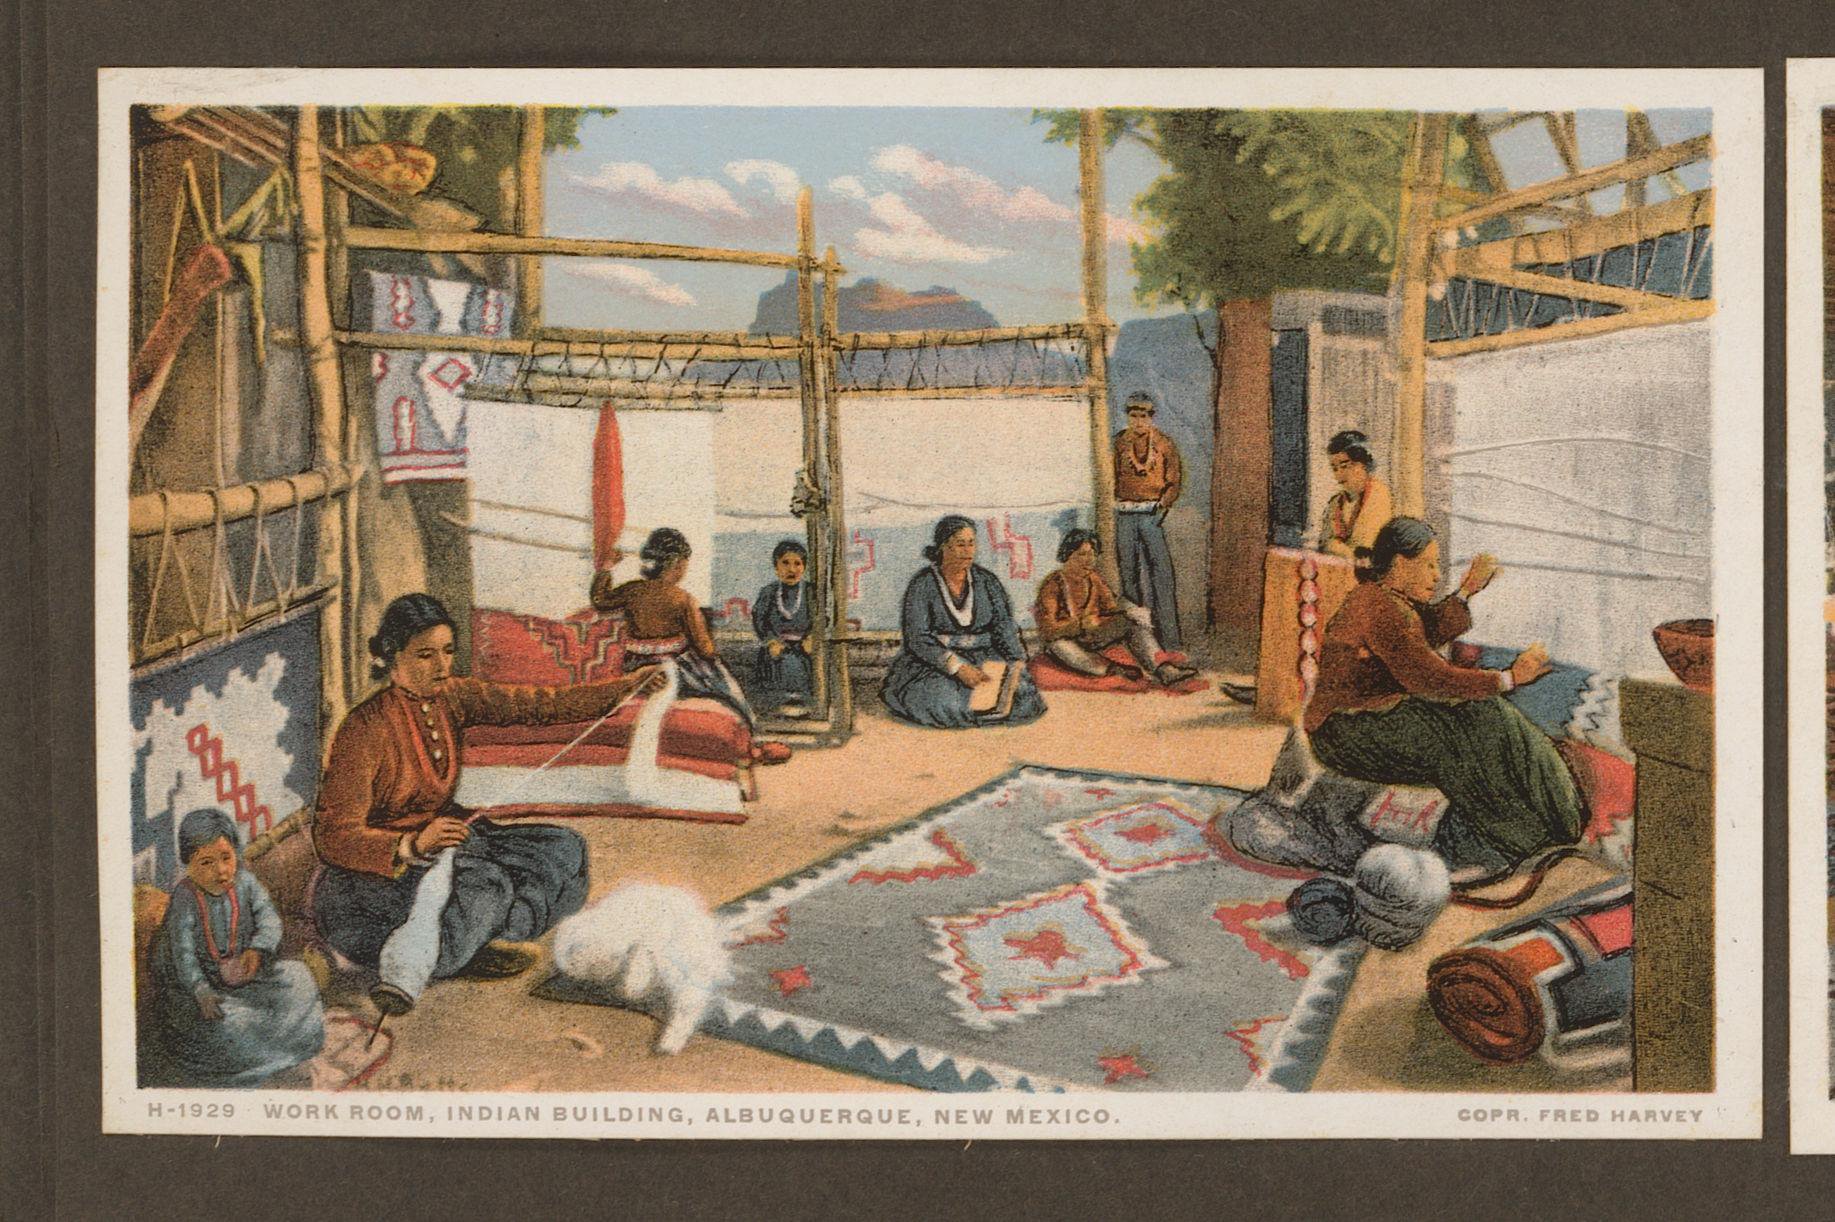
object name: album leaf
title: Work room, Indian building, Albuquerque, New Mexico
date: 1928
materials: paper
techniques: chromolithography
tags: adult woman, interior of the house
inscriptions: name: ‘Copr. Fred Harvey’, number: ‘H-1929’